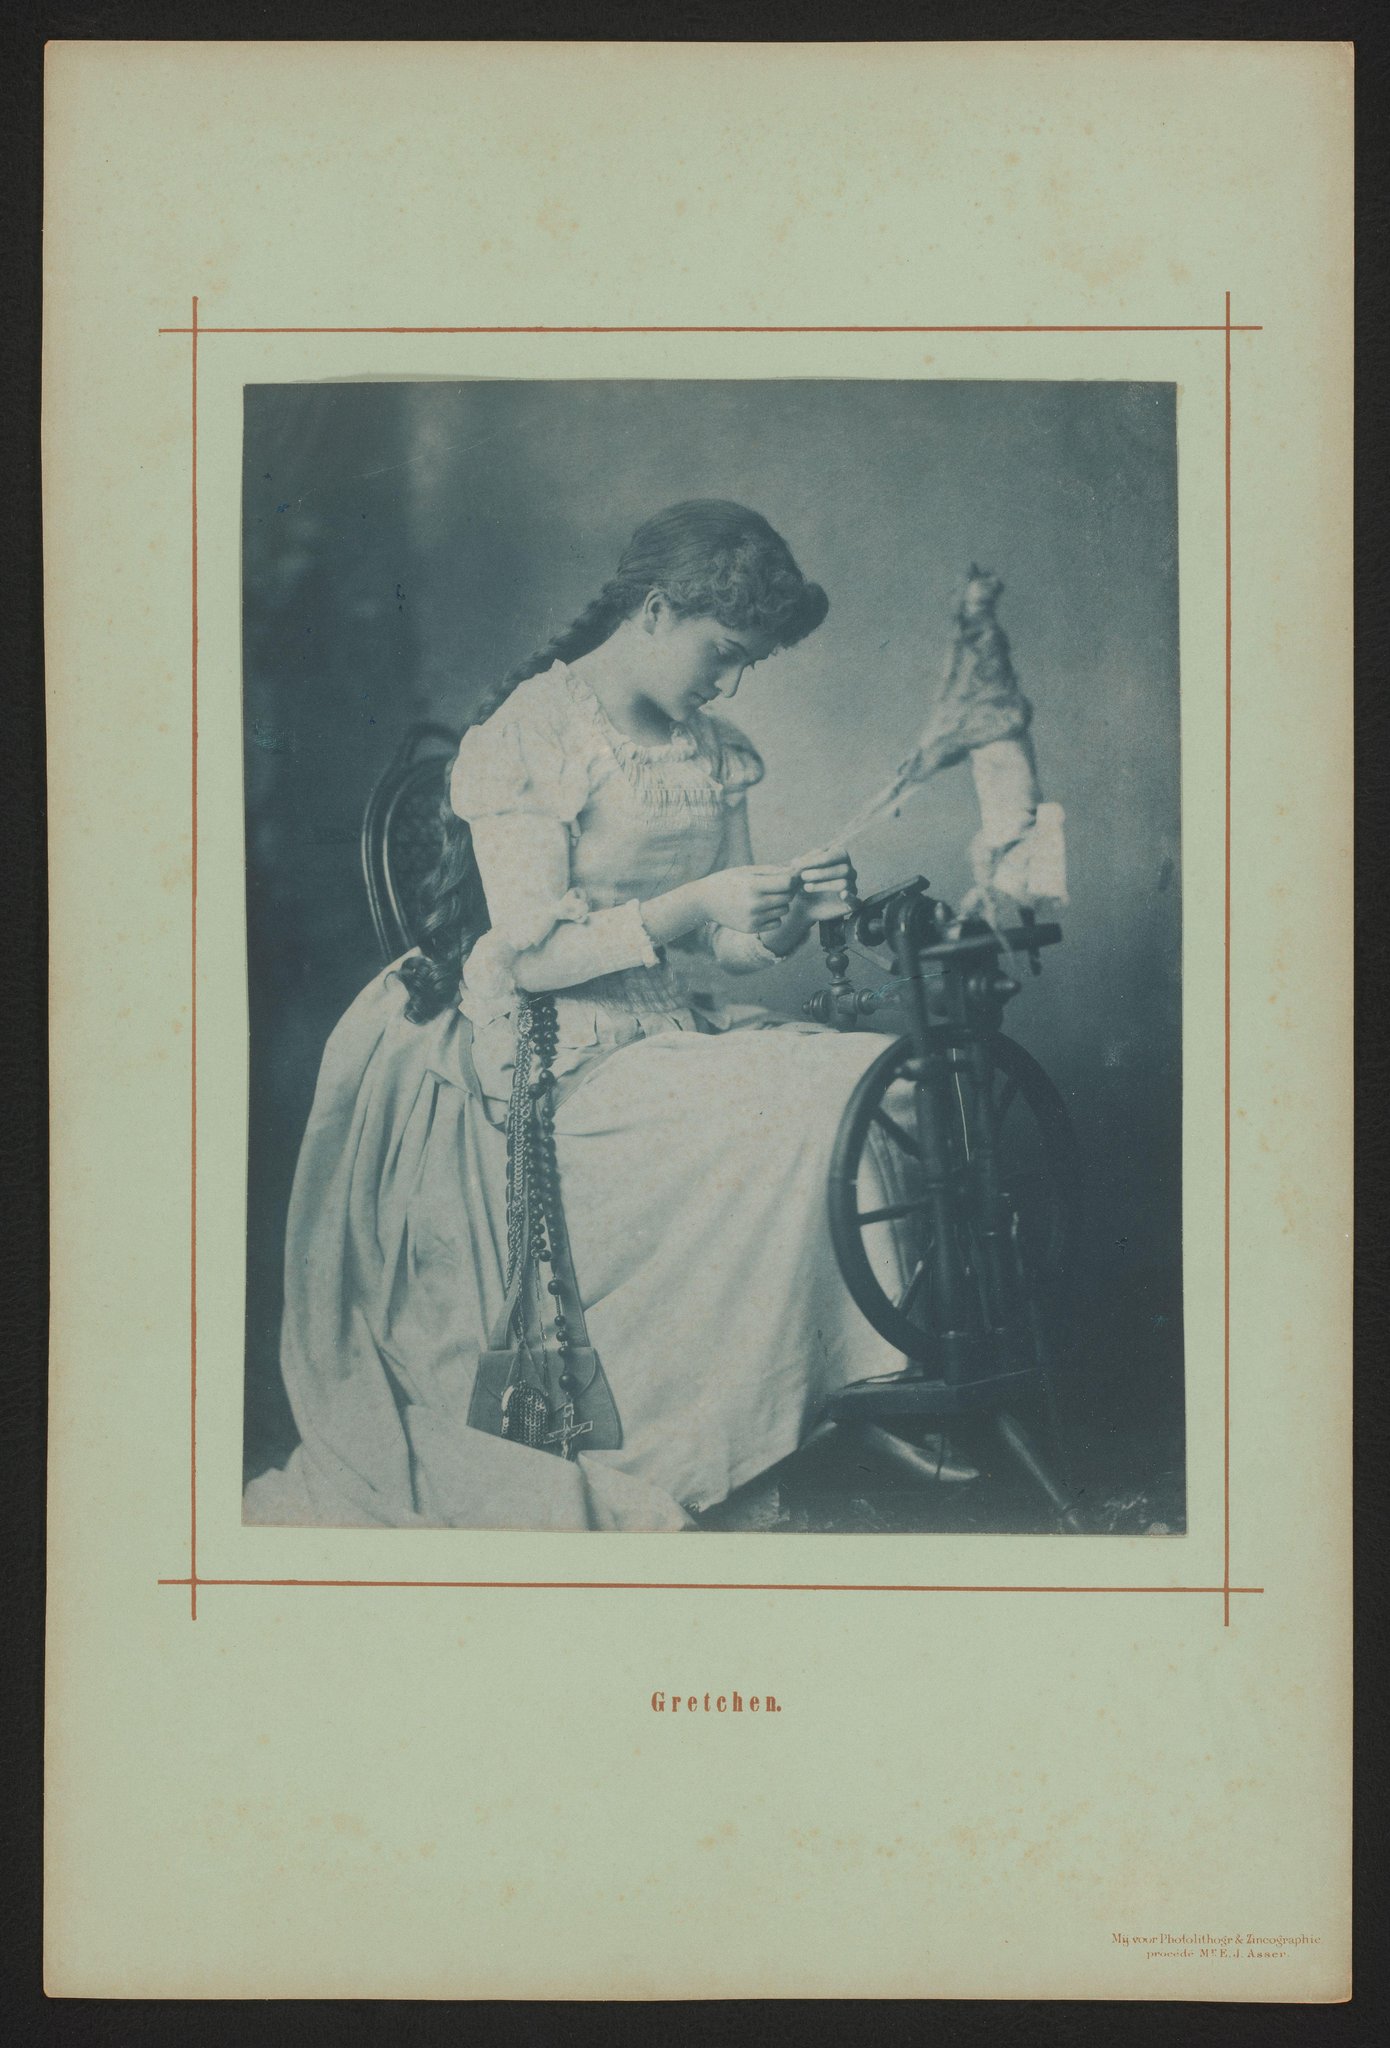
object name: photomechanical print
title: Genrescène uit Faust, Gretchen aan een spinnewiel, naar Goethe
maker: Anonymous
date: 1892-1900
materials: paper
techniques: photograph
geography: amsterdam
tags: adolescent, young woman, maiden, spinning-wheel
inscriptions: inscription: ‘Mij. voor Photolithogr & Zincographie/ procédé Mr. E.J. Asser.’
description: Deze prent maakt deel uit van een album.